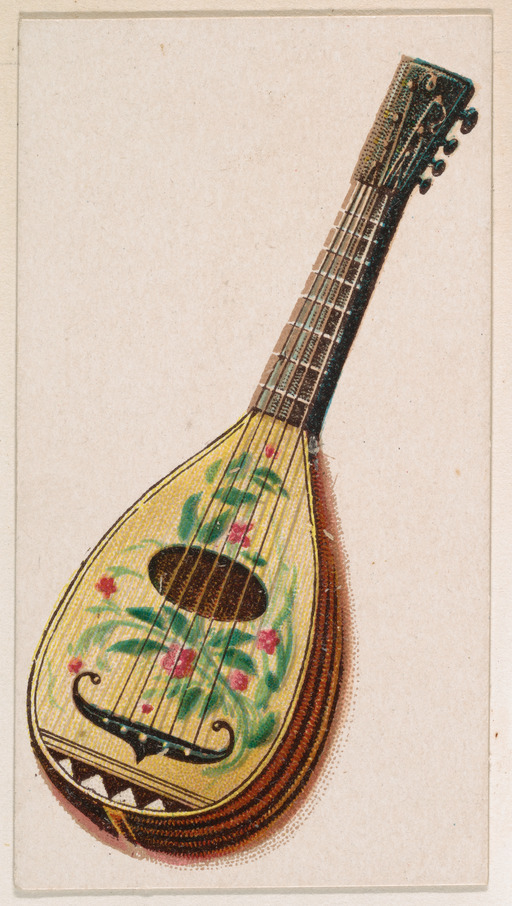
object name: print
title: Mandolin, from the Novelties series (N228, Type 5) issued by Kinney Bros.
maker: kinney brothers tobacco company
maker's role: publisher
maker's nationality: american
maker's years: 1869-2011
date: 1889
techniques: color lithograph